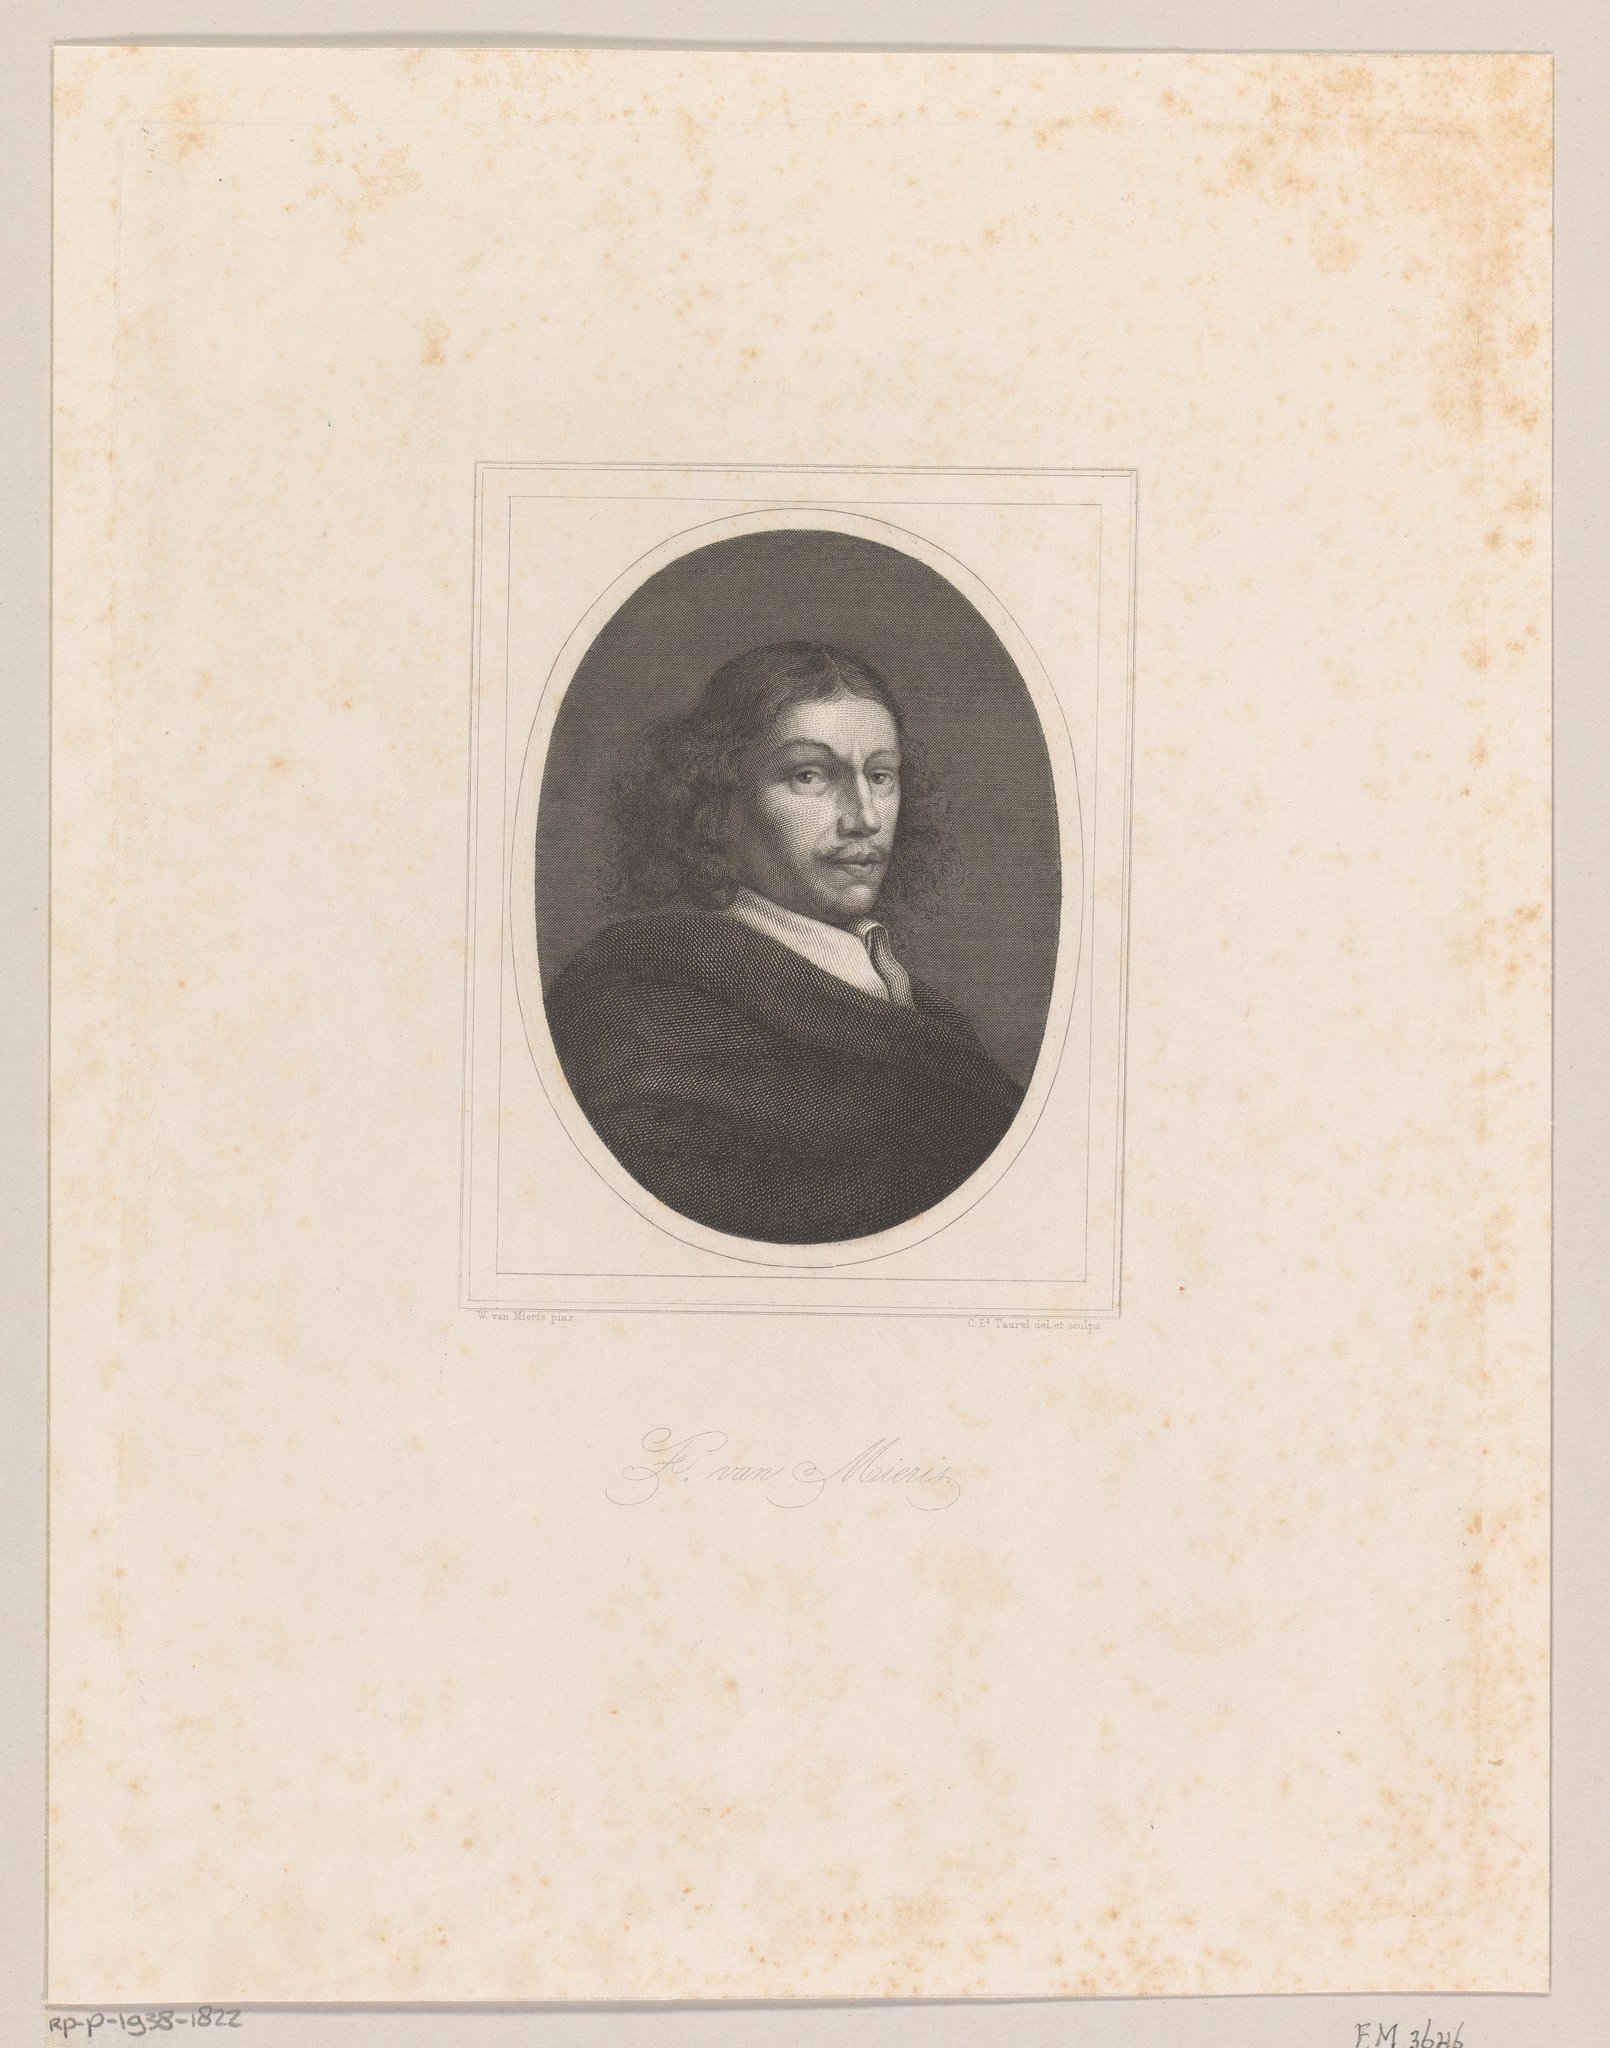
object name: print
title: Portret van Frans van Mieris (I)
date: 1839-1892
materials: paper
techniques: engraving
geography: amsterdam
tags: leiden, painter, print maker, draughtsman, frans van mieris (i), historical persons, portrait, self-portrait of painter, artist in non-work situation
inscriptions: collector's mark: Lugt 2228